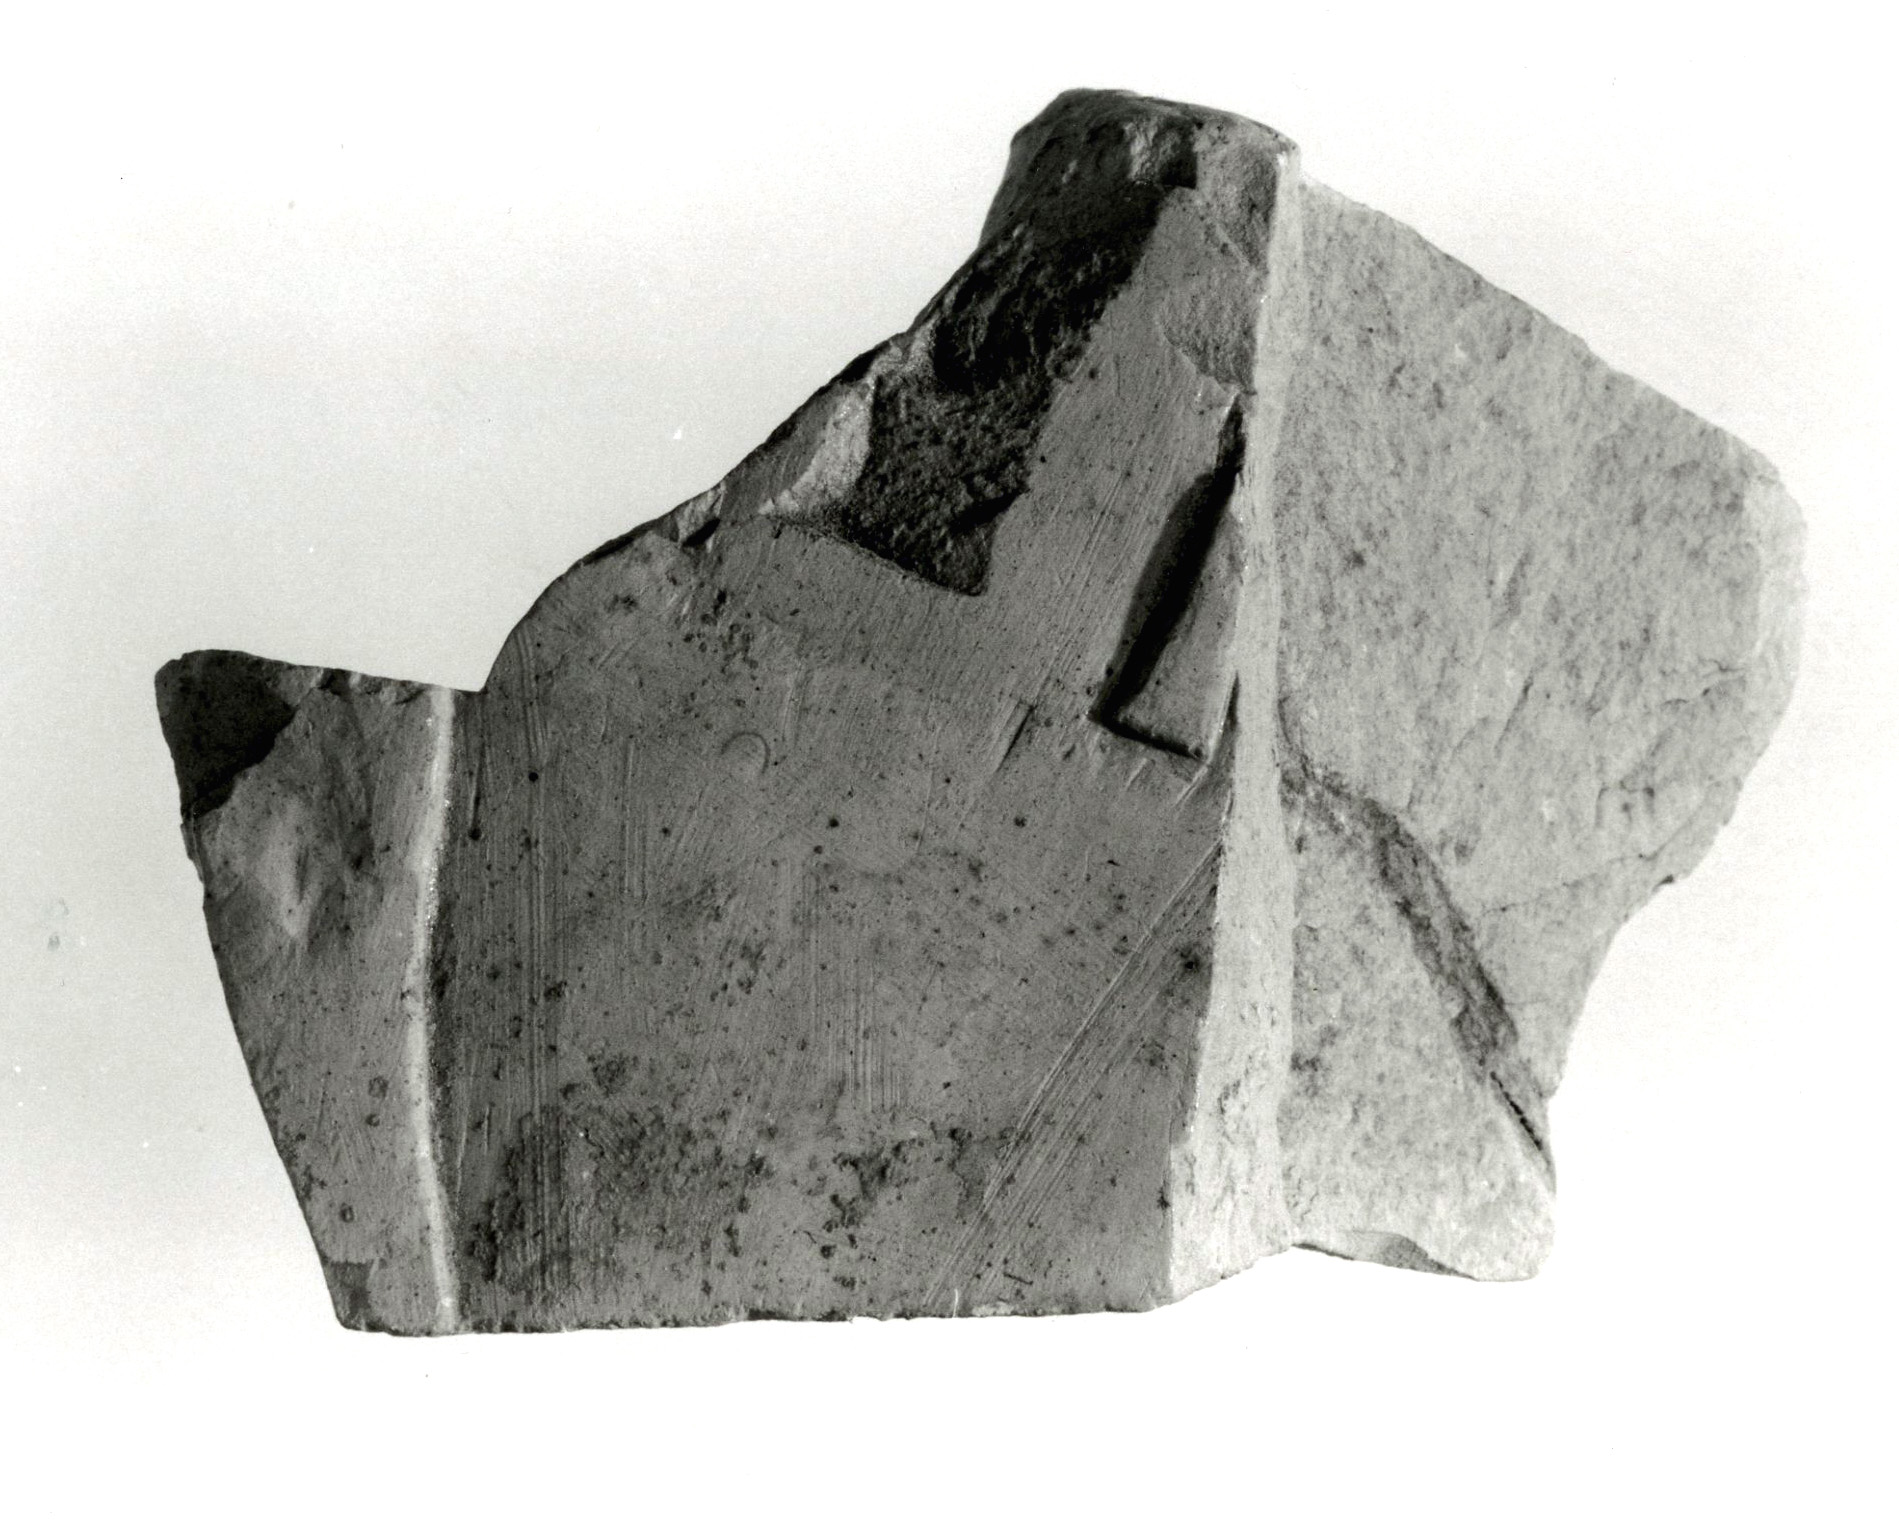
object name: relief, tomb of nespekashuty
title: Raised relief fragment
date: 664-610 BCE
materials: limestone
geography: egypt